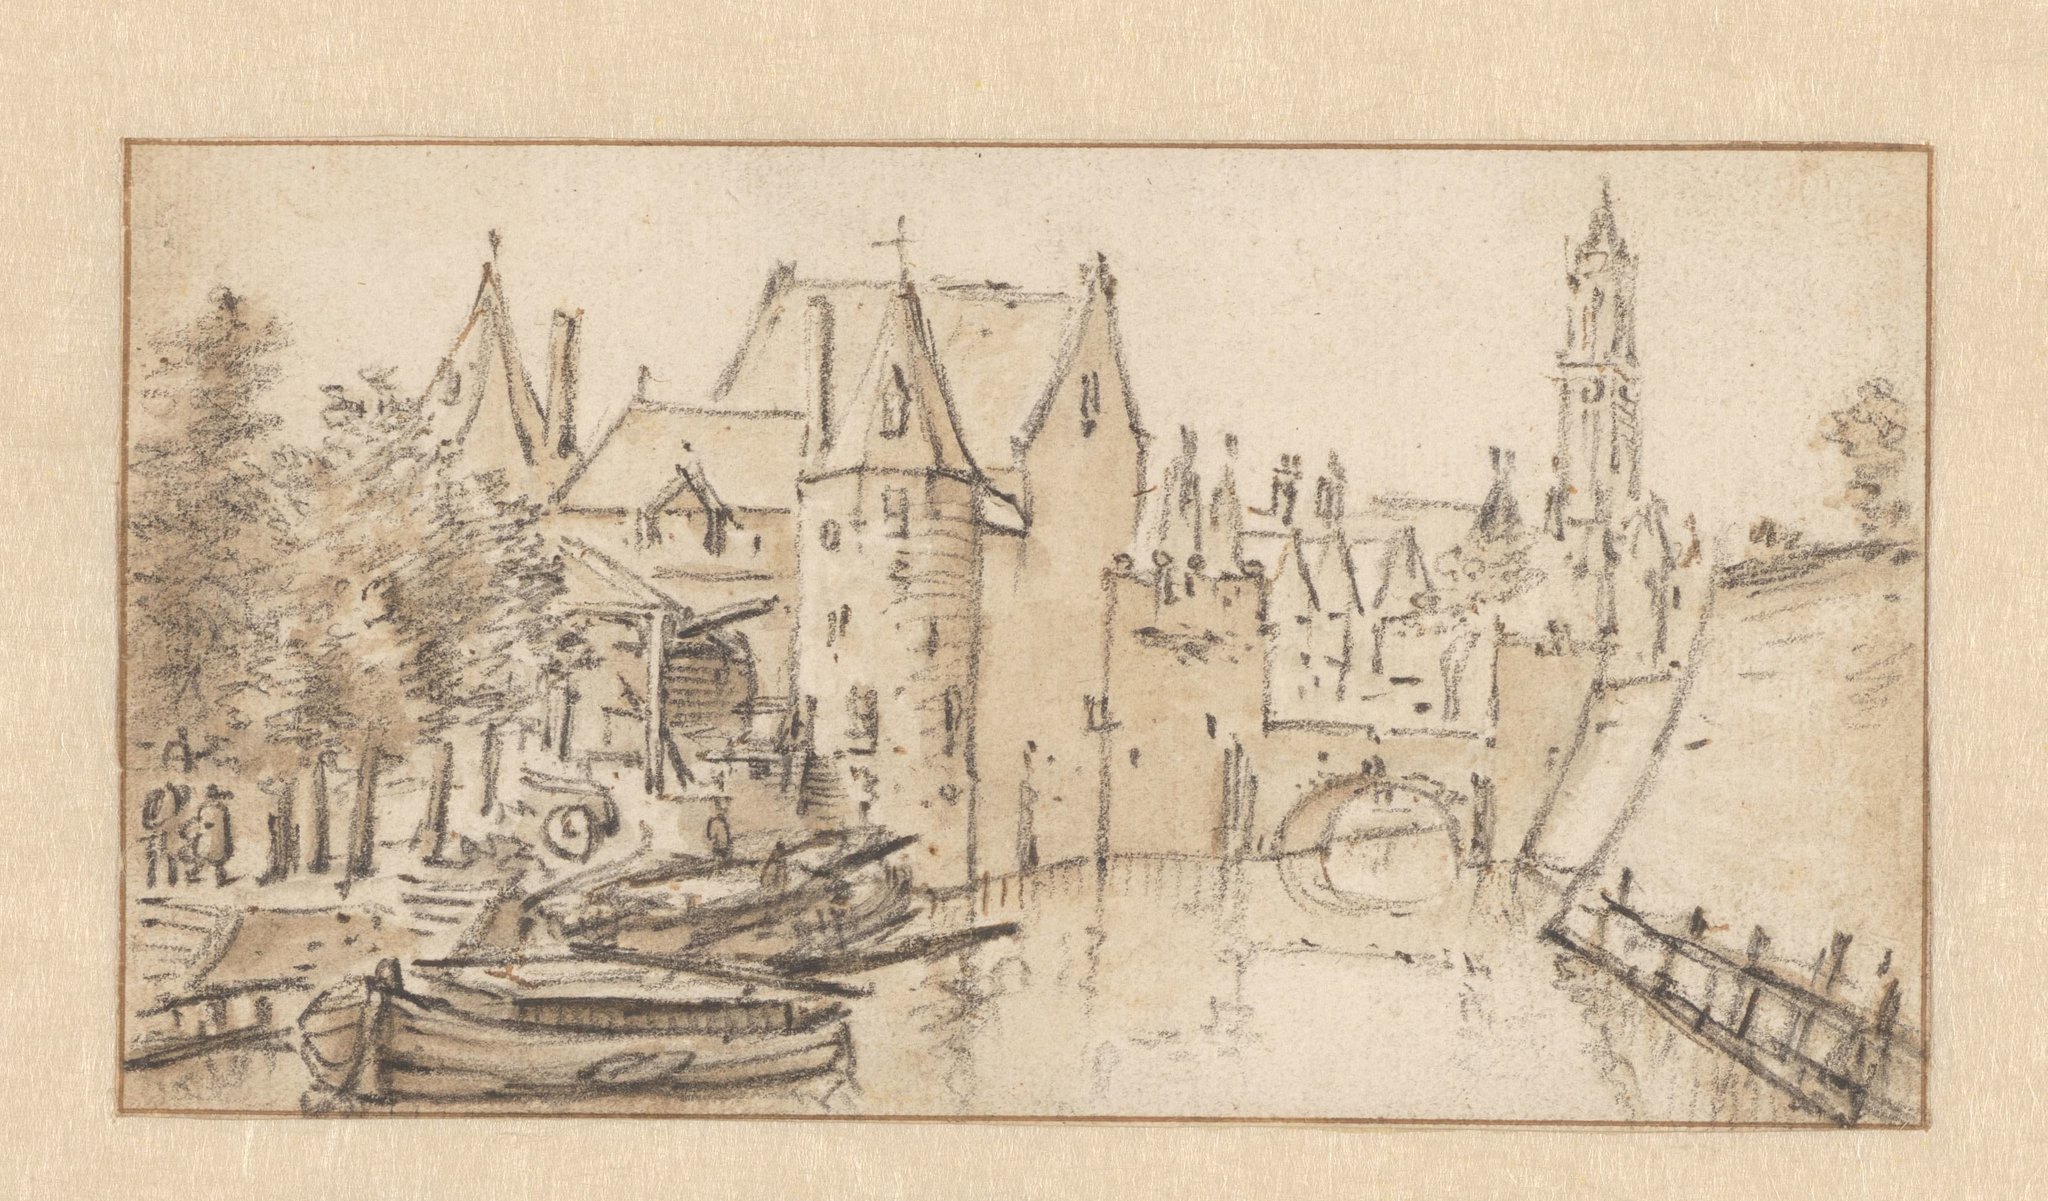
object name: drawing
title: Weerdpoort te Utrecht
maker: herman saftleven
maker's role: draughtsman, painter, print maker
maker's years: 1609-1685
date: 1619-1685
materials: chalk, paper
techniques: brush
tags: city-gate, utrecht